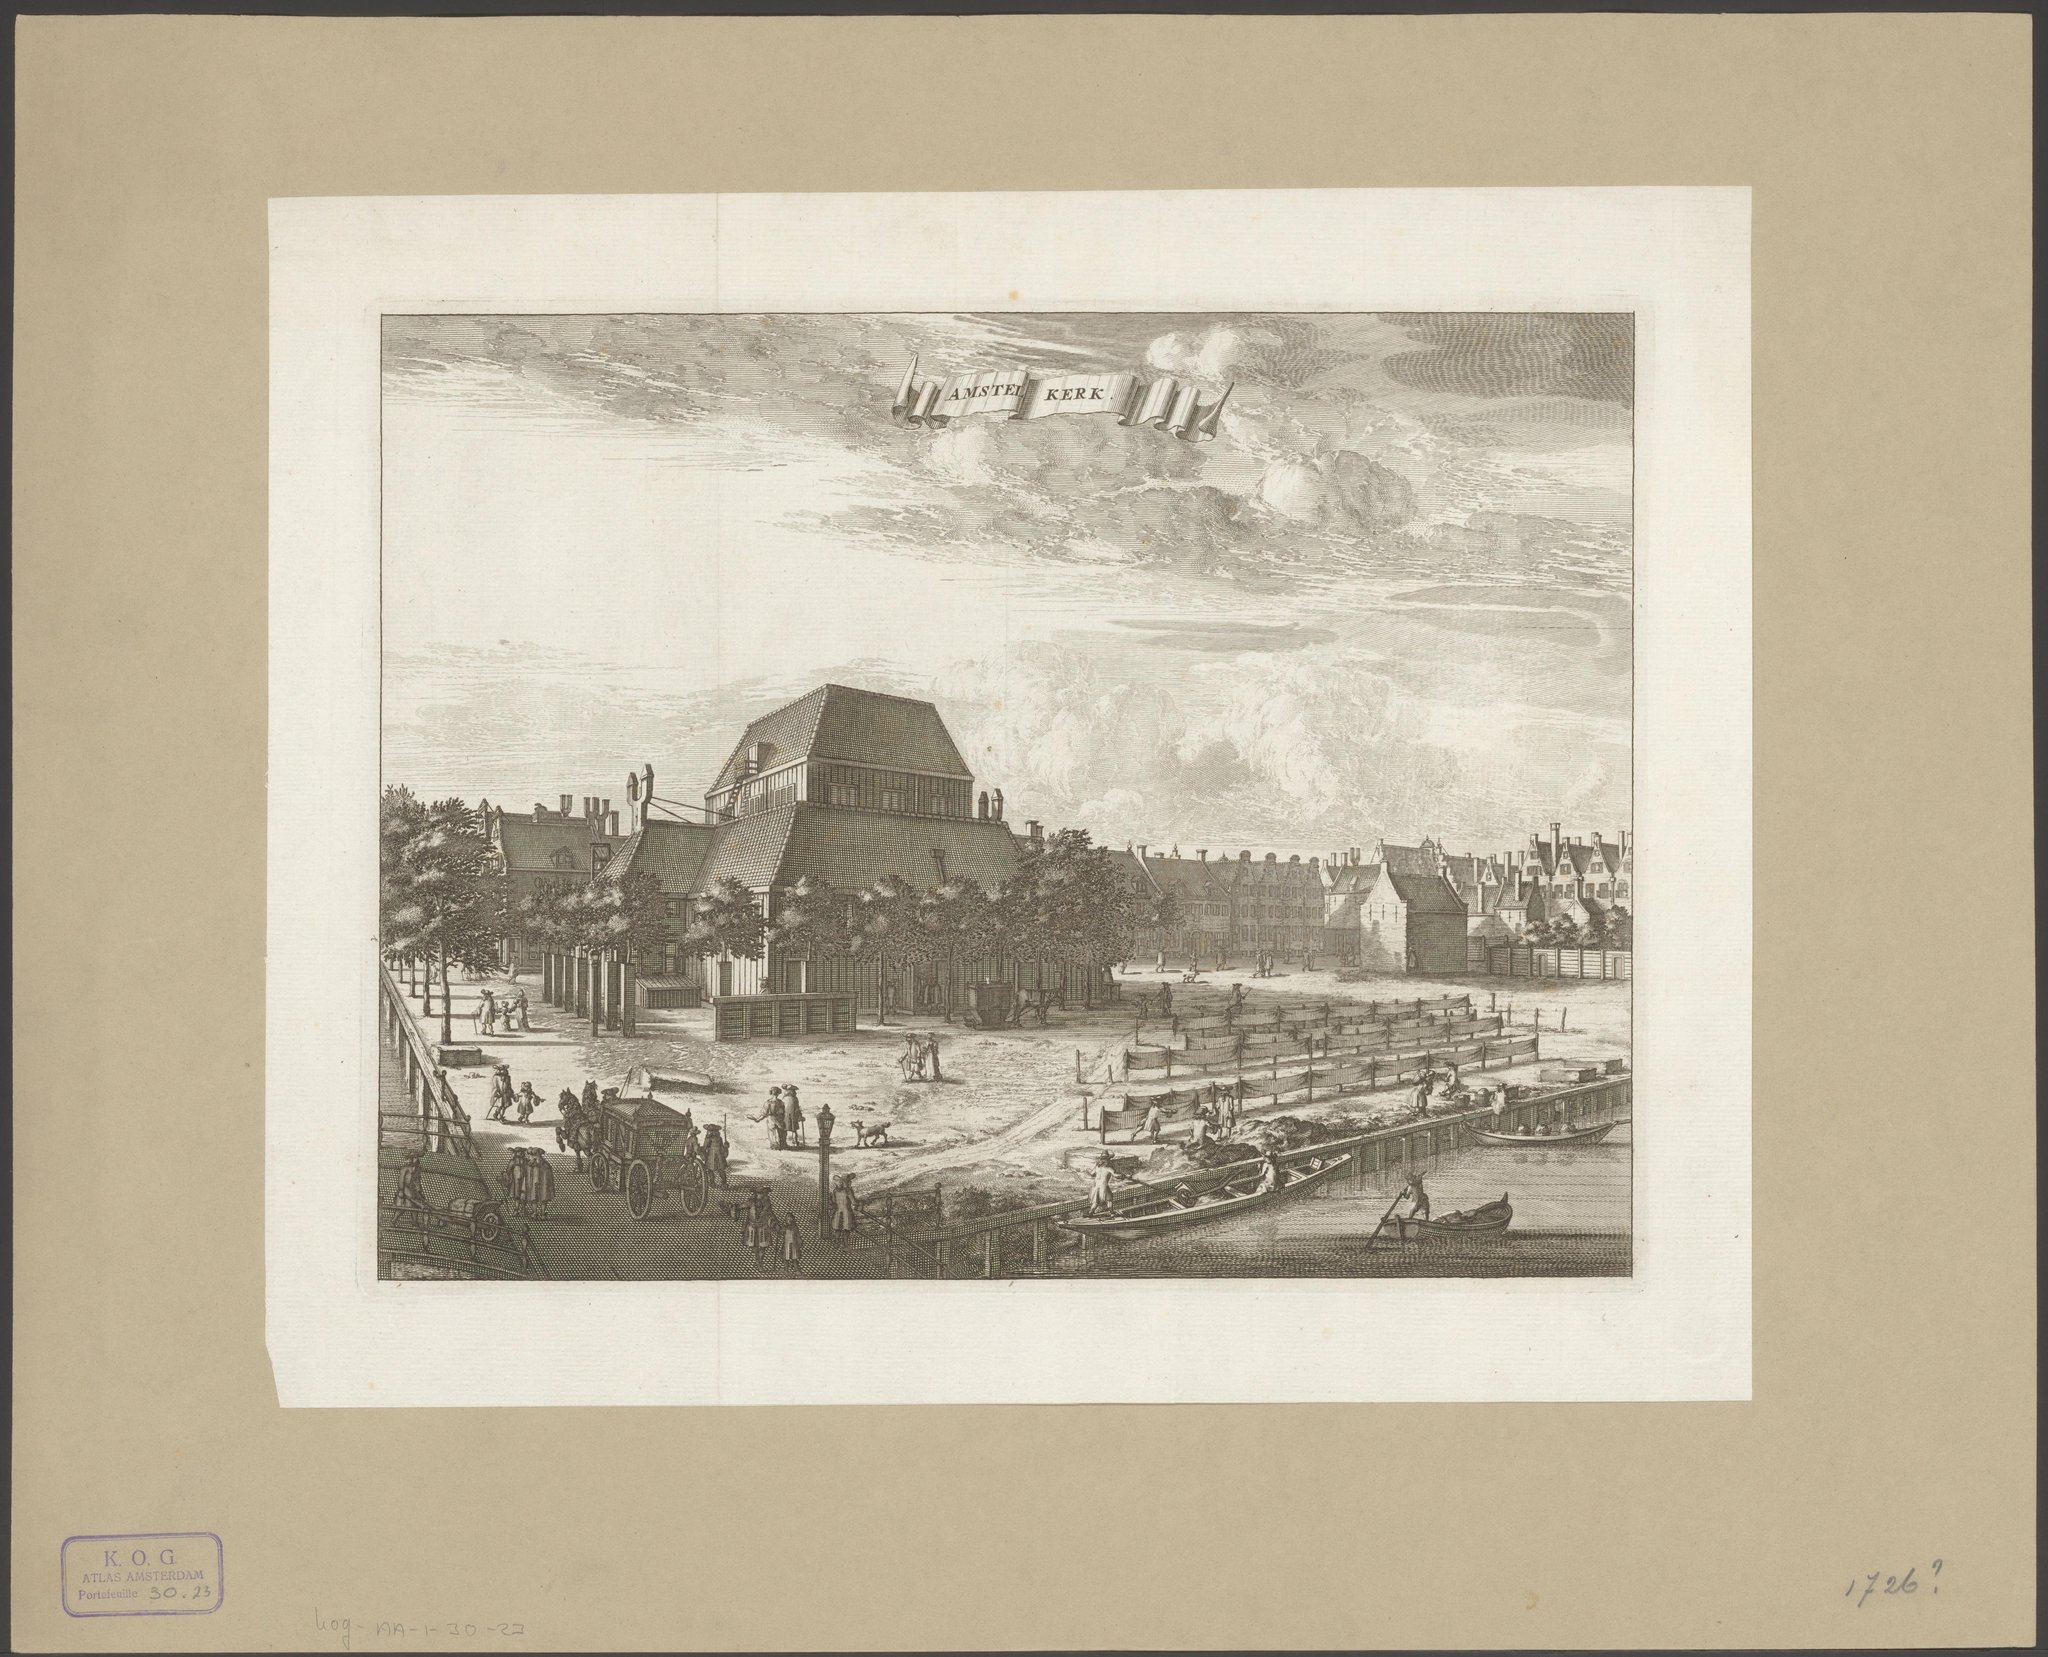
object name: print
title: Gezicht op de Amstelkerk te Amsterdam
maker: Anonymous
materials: paper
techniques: engraving, etching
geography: northern netherlands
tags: church (exterior), rowing-boat, canoe, etc., four-wheeled vehicle drawn by two animals, city-view, and landscape with man-made constructions (+ city(-scape) with figures, staffage)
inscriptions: collector's mark: Lugt 1641b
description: Eerste staat van prent gebruikt in: Commelin, Casparus. Beschryvinge van Amsterdam (…). Amsterdam: Abraham Wolfgang, Gillis Janssonius van Waesberge of Johannes Janssonius van Waesberge, Hendrick Boom of weduwe Dirk Boom, Abraham van Sanderen en Rembertus Goethals, 1693, dl. 1. En in: Commelin, Casparus. Beschryvinge van Amsterdam (…). Amsterdam: weduwe Aart Dircksz. Oossaan, 1694, dl. 1. Twee staat van prent gebruikt in: Commelin, Casparus. Beschryvinge van Amsterdam (…). 2de druk. Amsterdam: Andries van Damme, Johannes Ratelband, weduwe Antony van Aeltwijk en Hermanus Uytwerf, 1726, dl. 1.